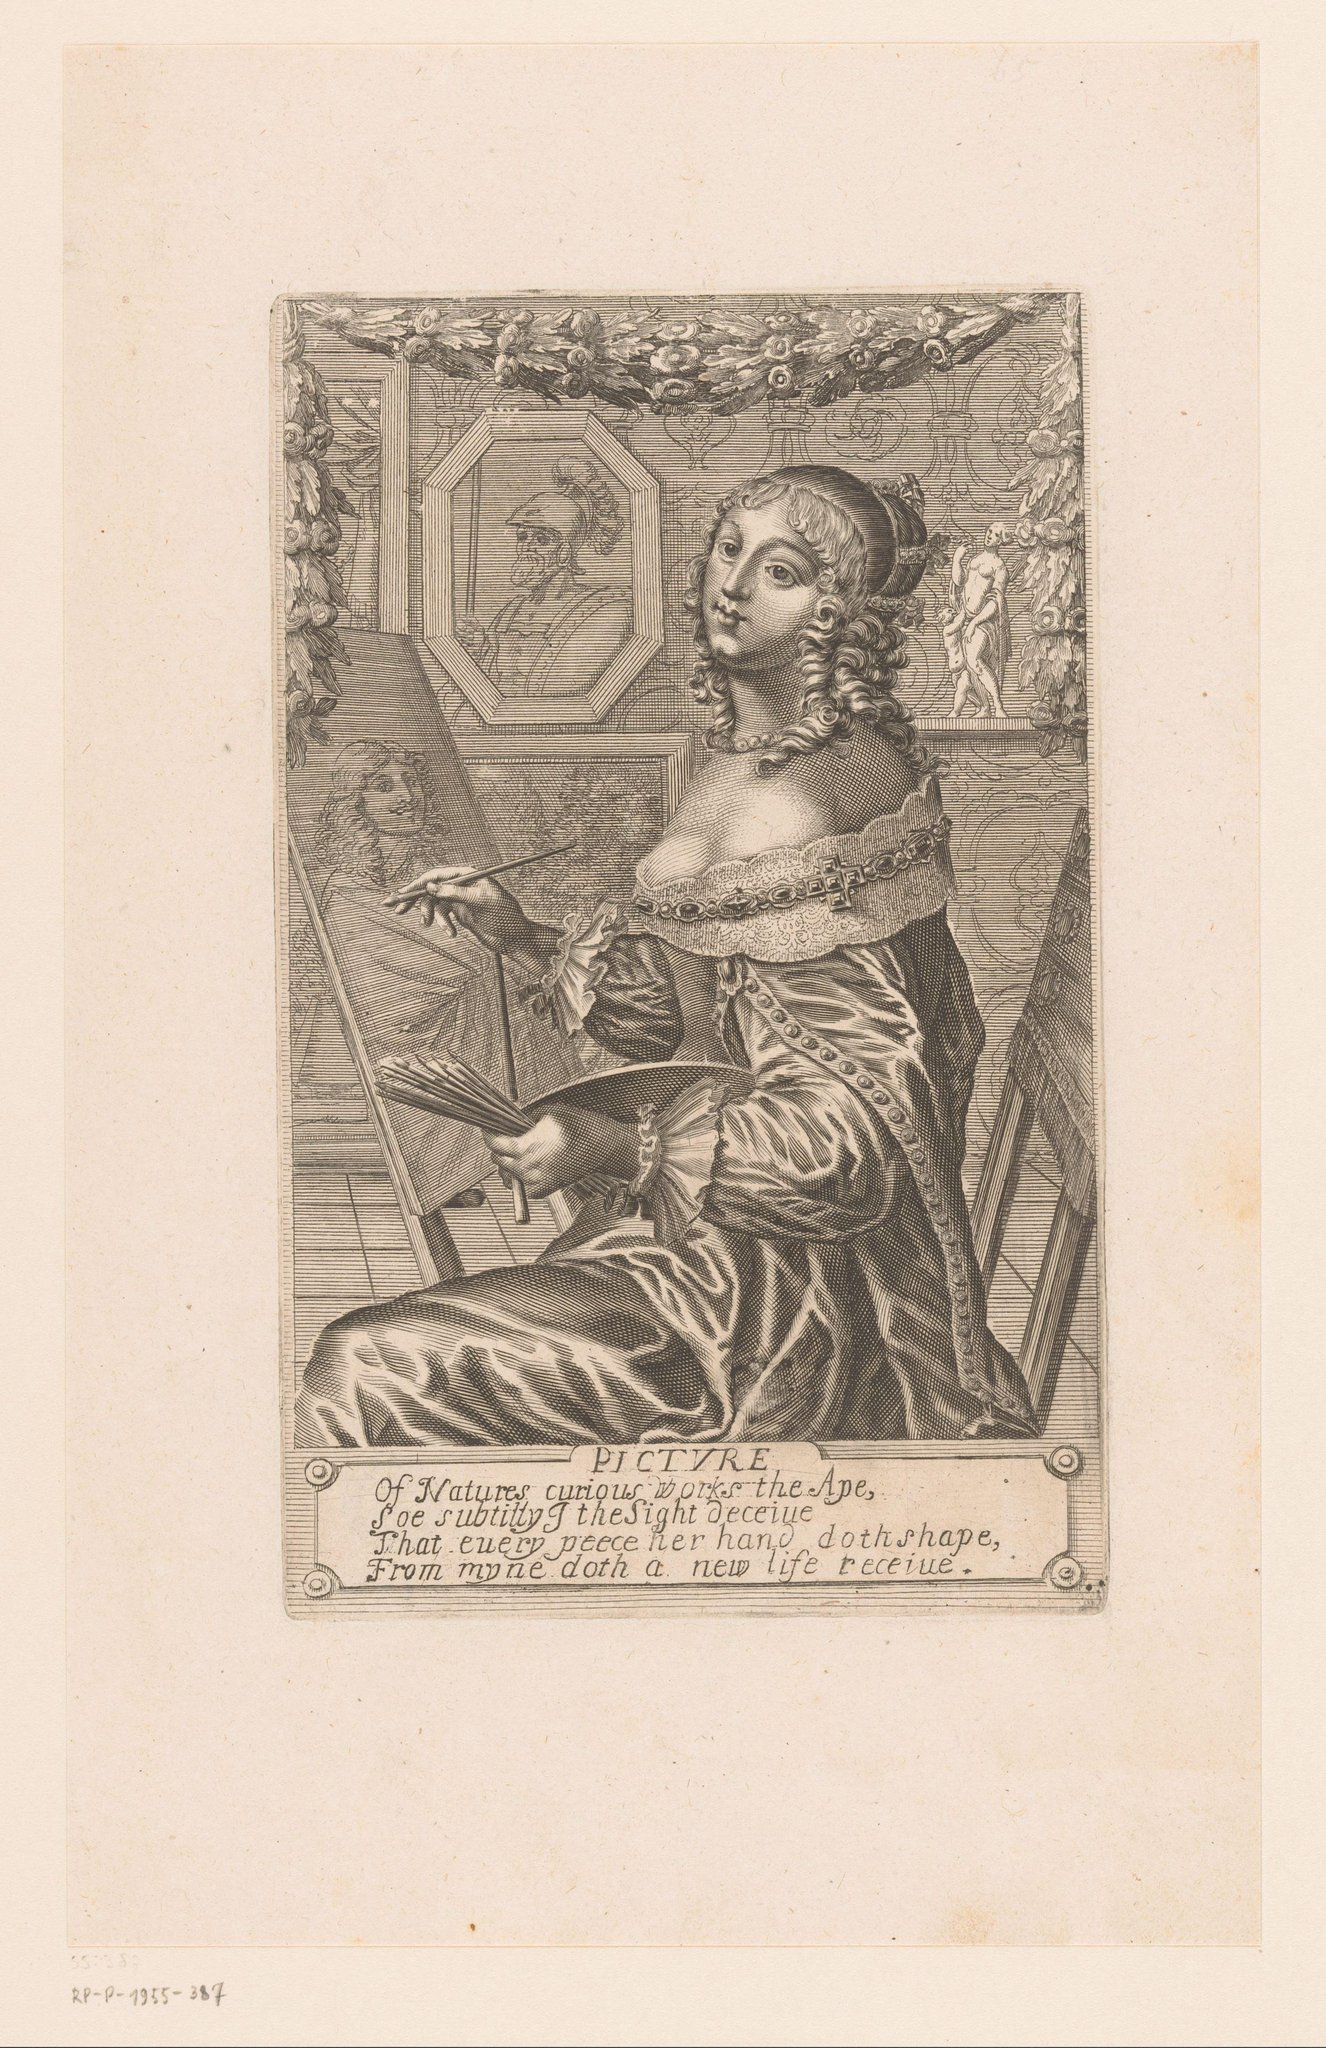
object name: print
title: Minerva et septem liberales artes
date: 1623-1681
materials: paper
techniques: engraving, etching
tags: 'pictura', symbolic representations, allegories and emblems ~ painting; 'pittura' (ripa)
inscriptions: collector's mark: Lugt 2228, collector's mark: Lugt 847a, collector's mark: Lugt 919ter